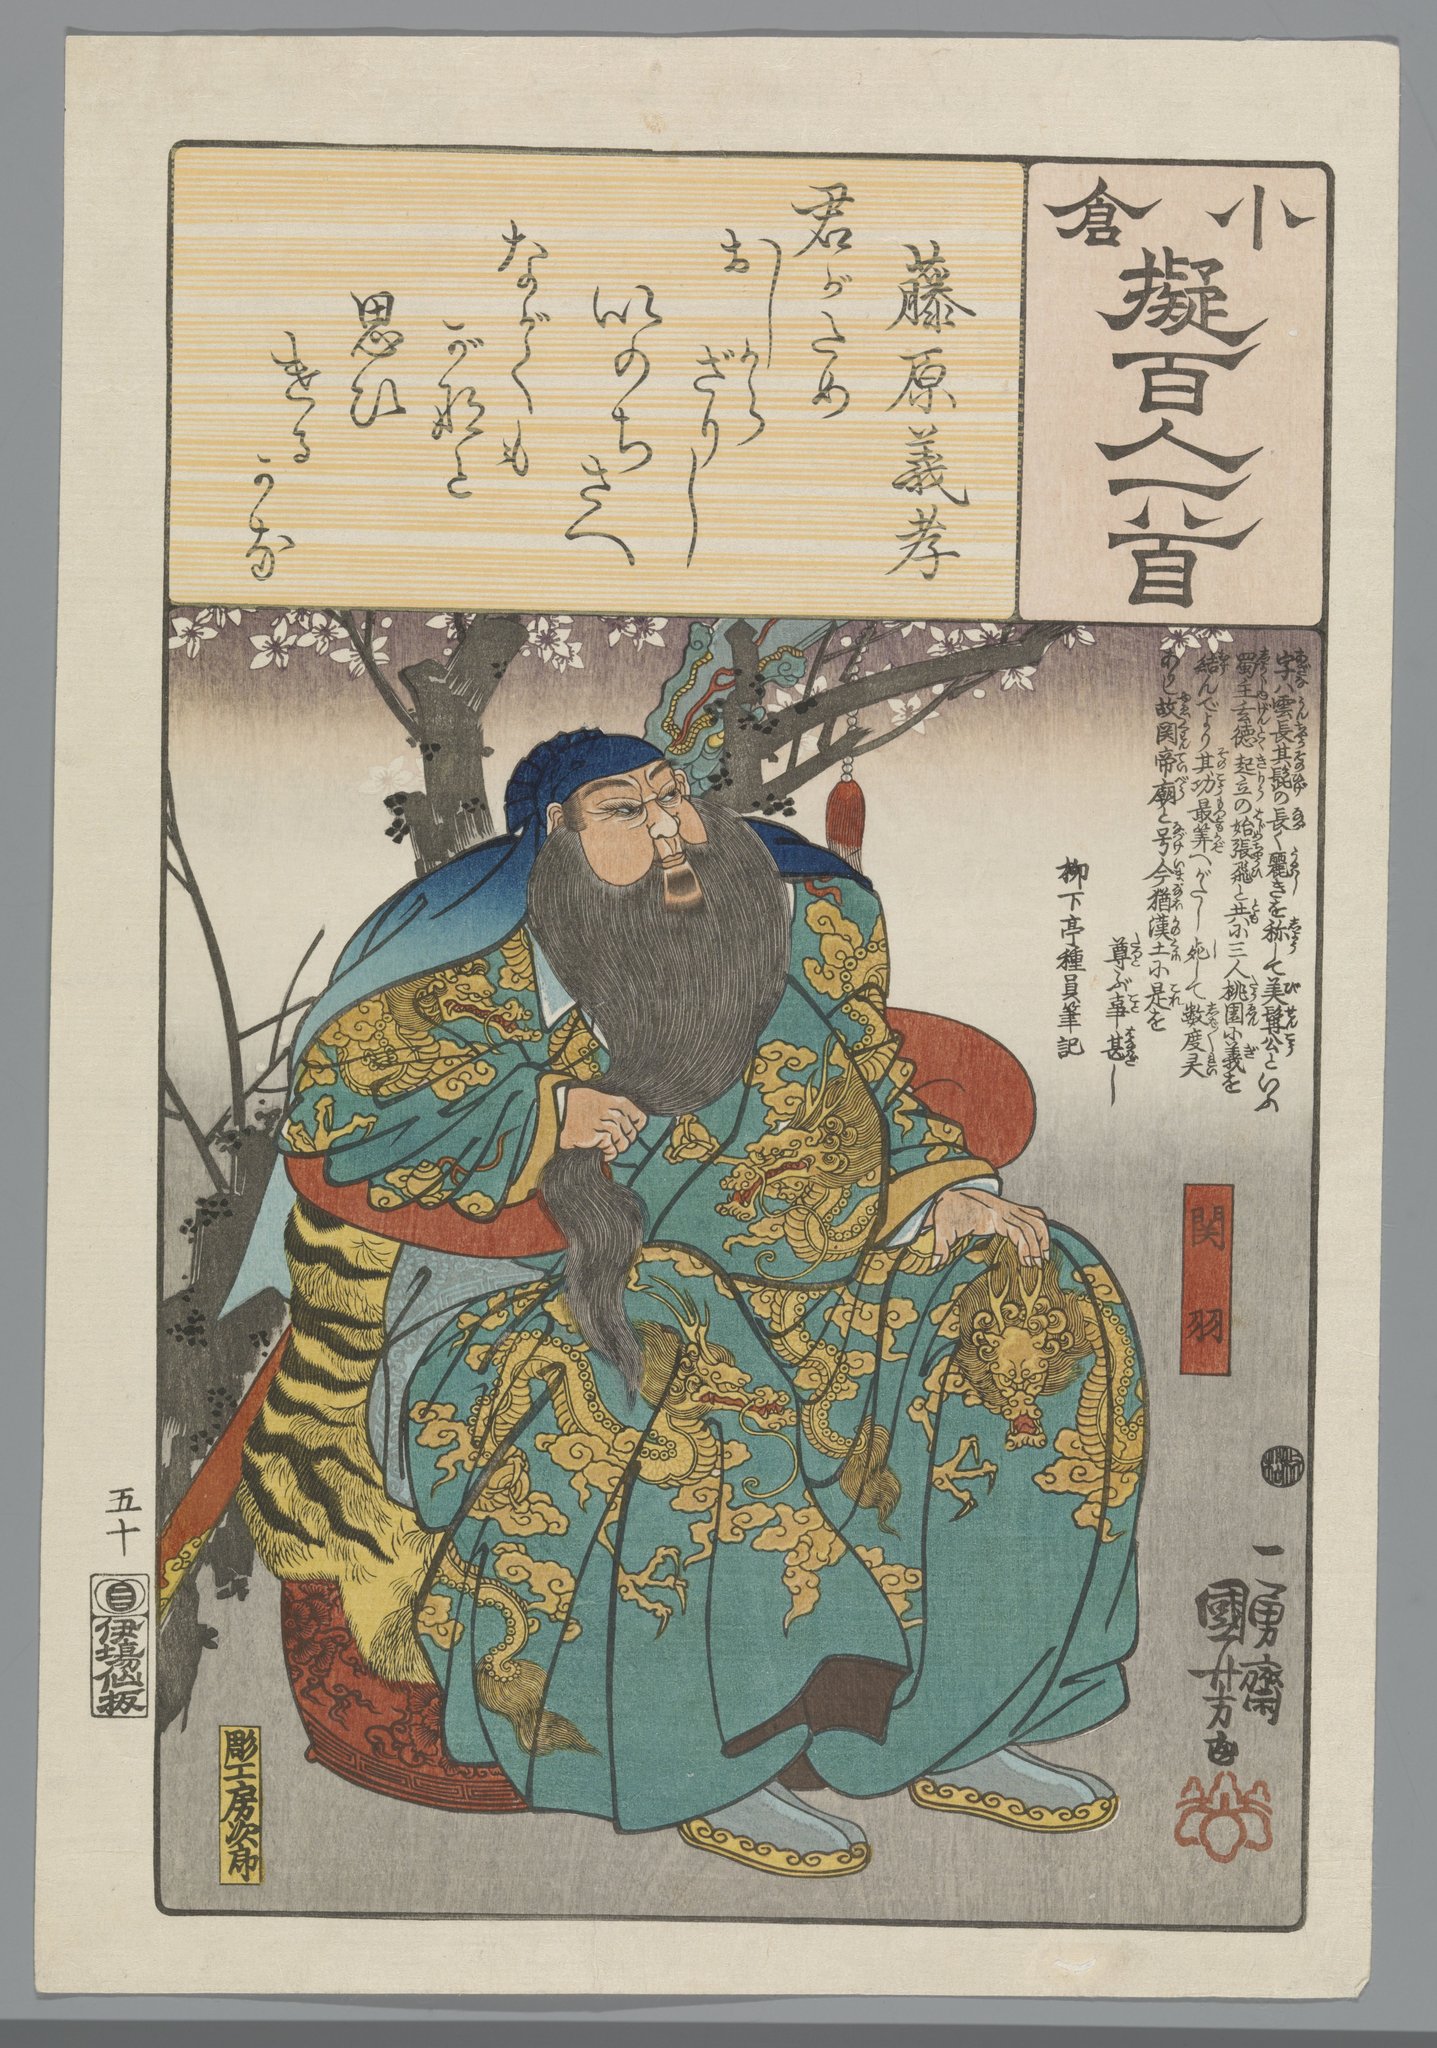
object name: print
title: Ogura Imitation of the One Hundred Poems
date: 1846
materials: paper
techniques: woodcut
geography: japan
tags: trees: peach-tree, person with big beard, helved weapons, polearms (for striking, hacking, thrusting): halberd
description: De Chinese Kan U, herkenbaar aan zijn enorme baard, zijn kostuum met goudkleurige draken en zijn hellebaard, zit onder een bloeiende perzikboom. Scene uit een kabukitoneelstuk. Gedicht door Fujiwara no Yoshitaka.